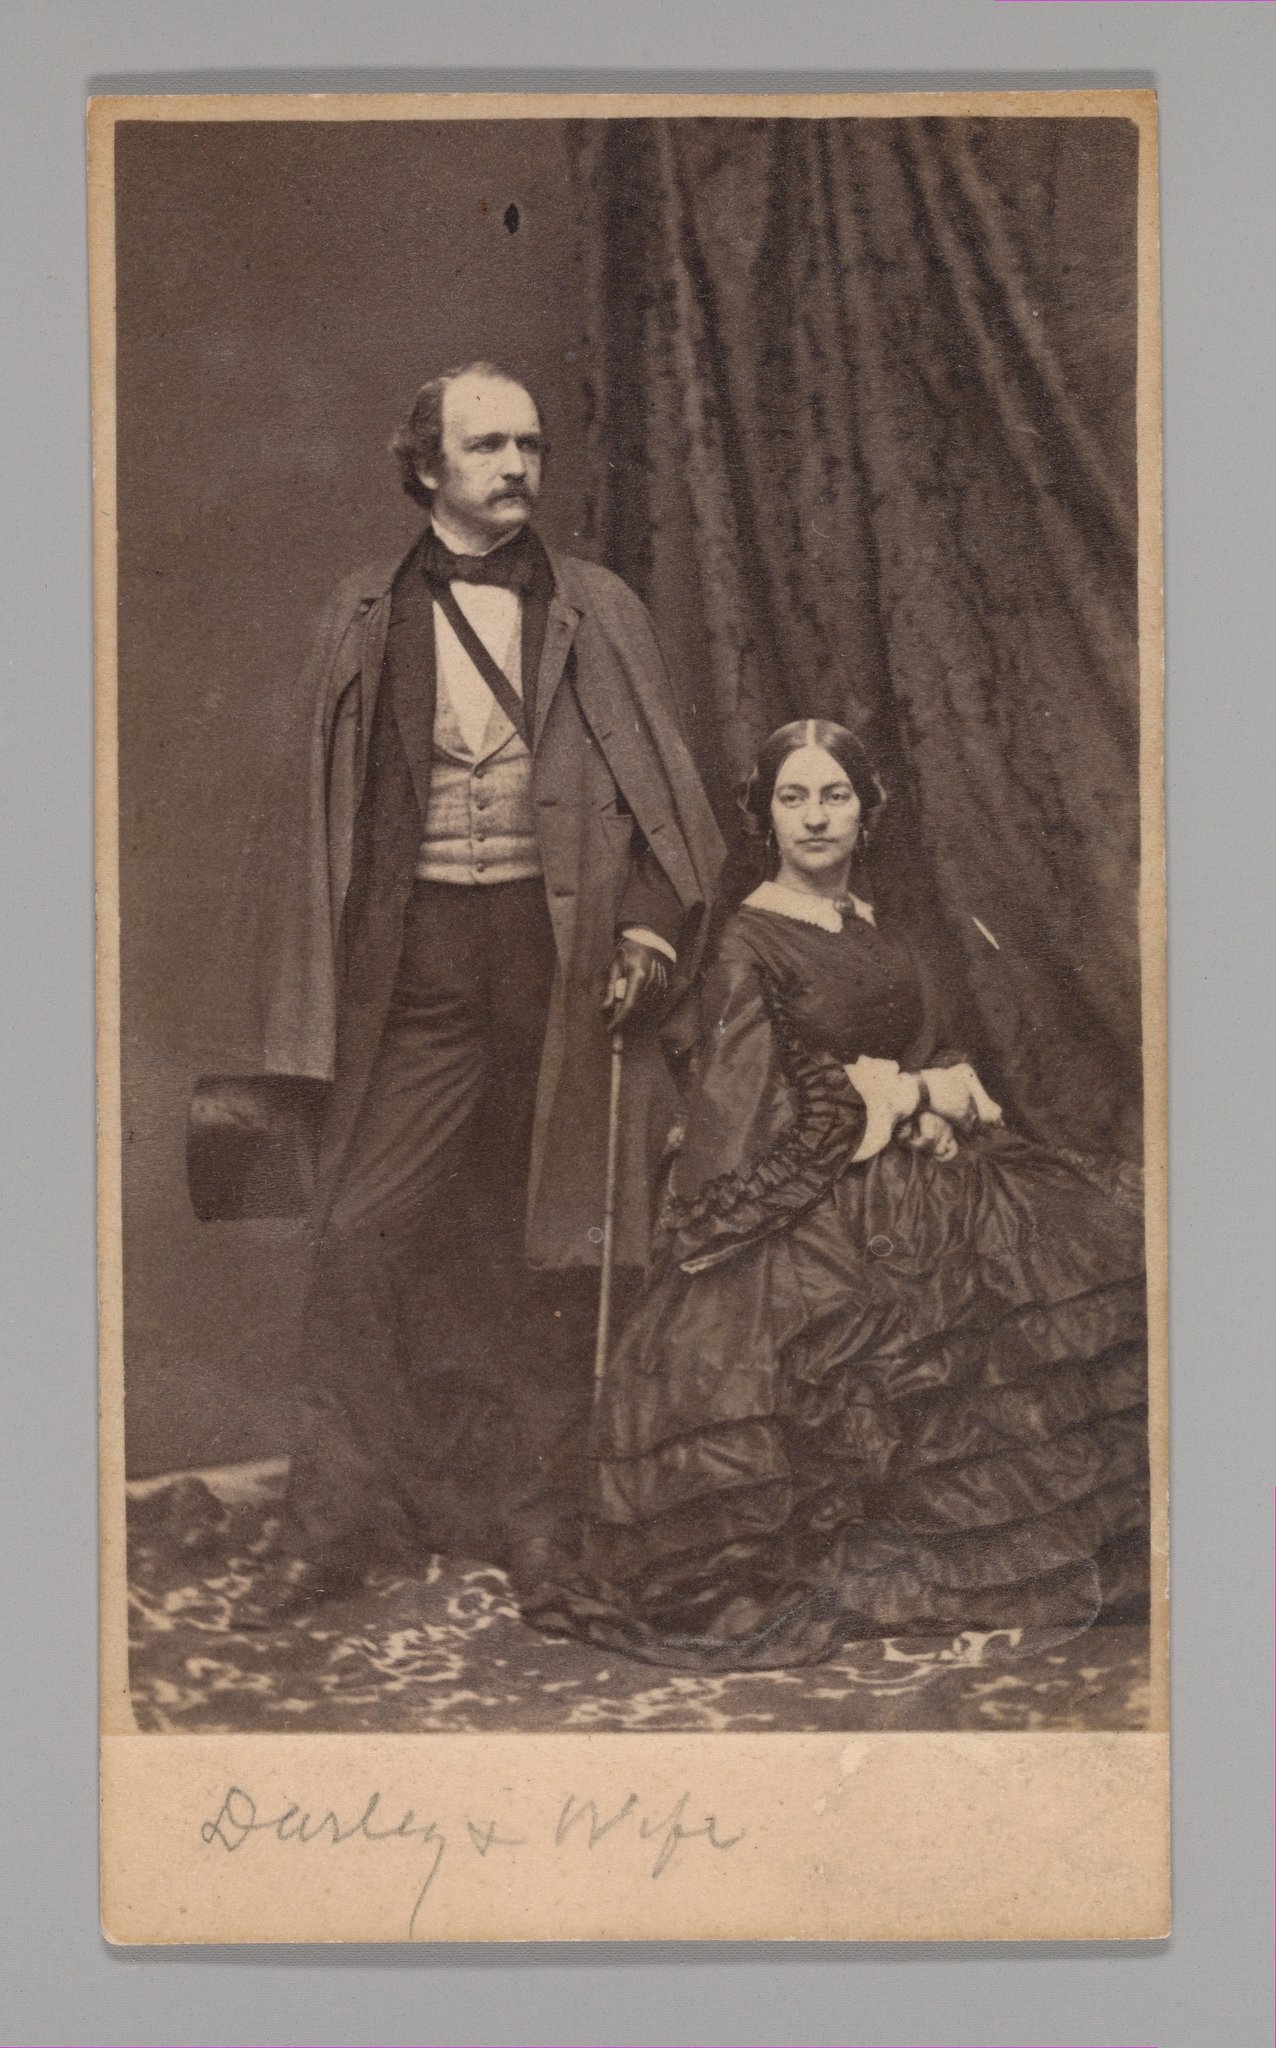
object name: carte de visite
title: [Unknown Subject]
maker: Anonymous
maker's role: artist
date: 1860-1869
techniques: albumen silver print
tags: men,portraits,women